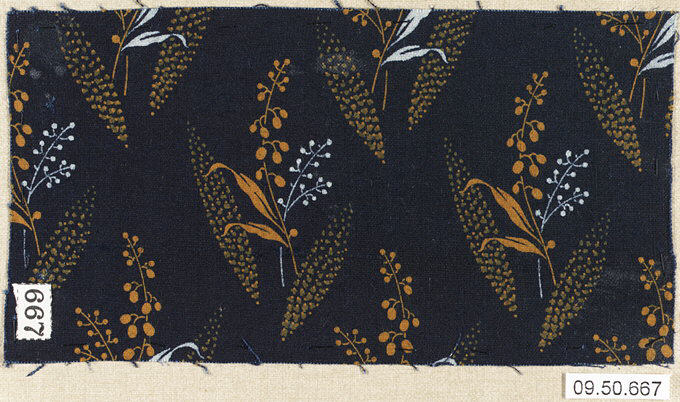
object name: piece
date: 1801-1900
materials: cotton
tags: flowers,leaves